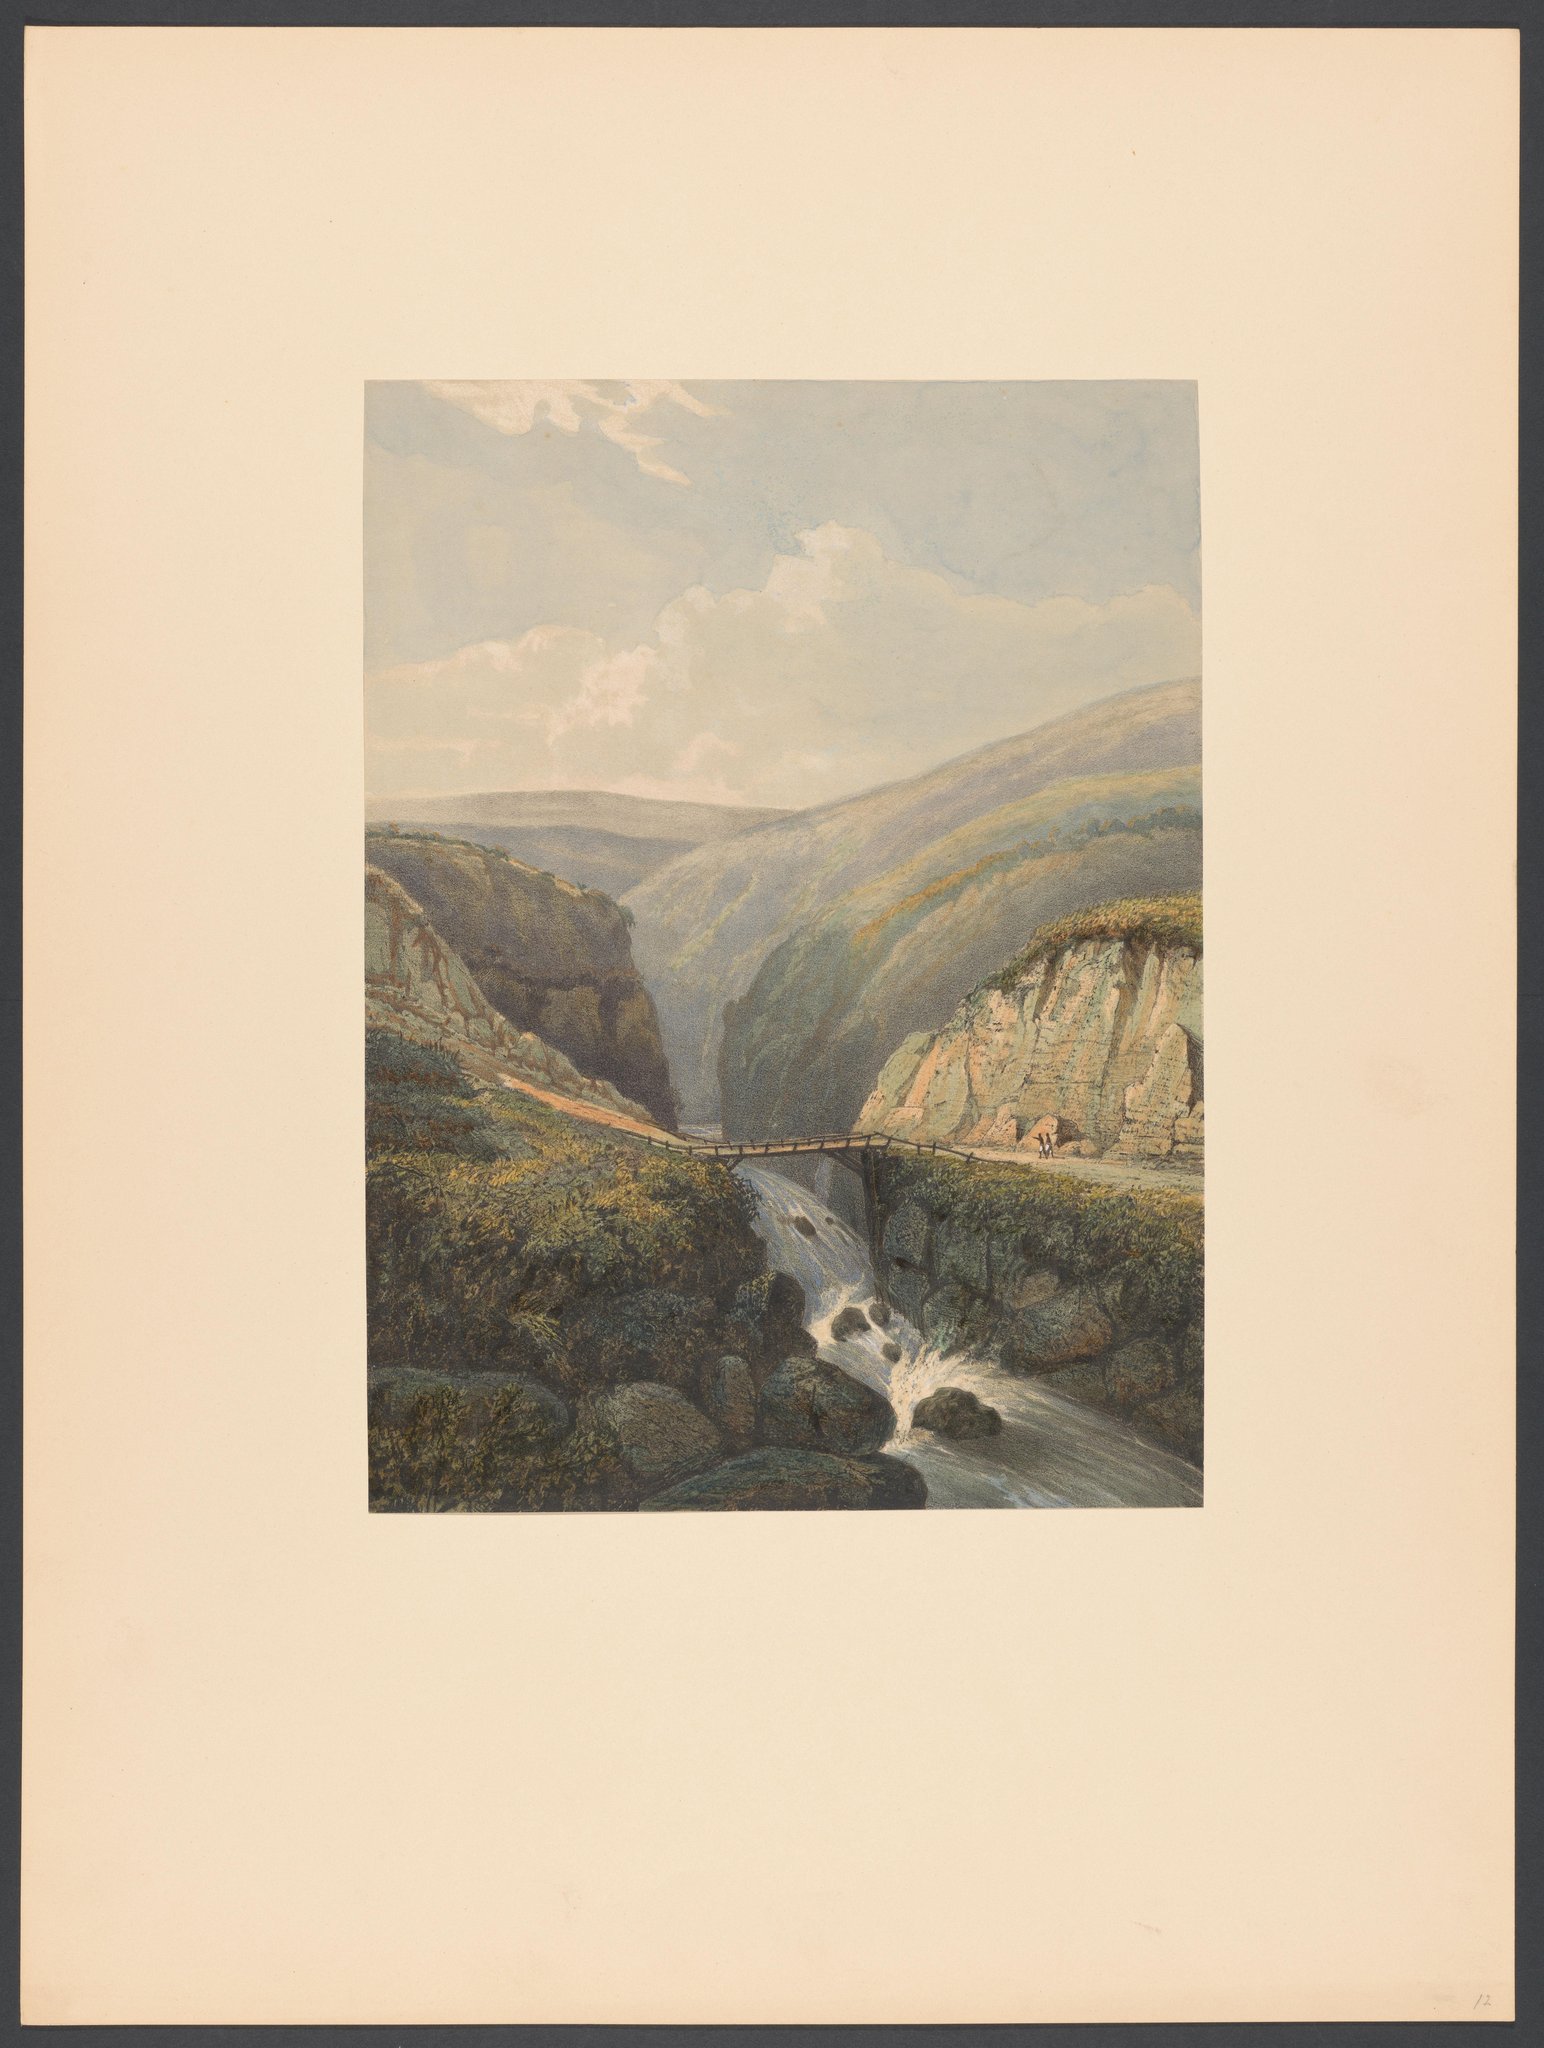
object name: print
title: Java naar schilderijen en teekeningen van A. Salm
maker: johan conrad greive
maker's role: draughtsman, painter, print maker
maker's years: 1837-1891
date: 1865-1872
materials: paper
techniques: lithograph, hand coloring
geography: java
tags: landscape with bridge, viaduct or aqueduct, landscapes with waters, waterscapes, seascapes (in the temperate zone) (+ landscape with figures, staffage), spring, source of river or stream, mountains, java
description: Volgens de bijbehorende inhoudsopgave betreft dit de 12de prent uit de reeks van 24.